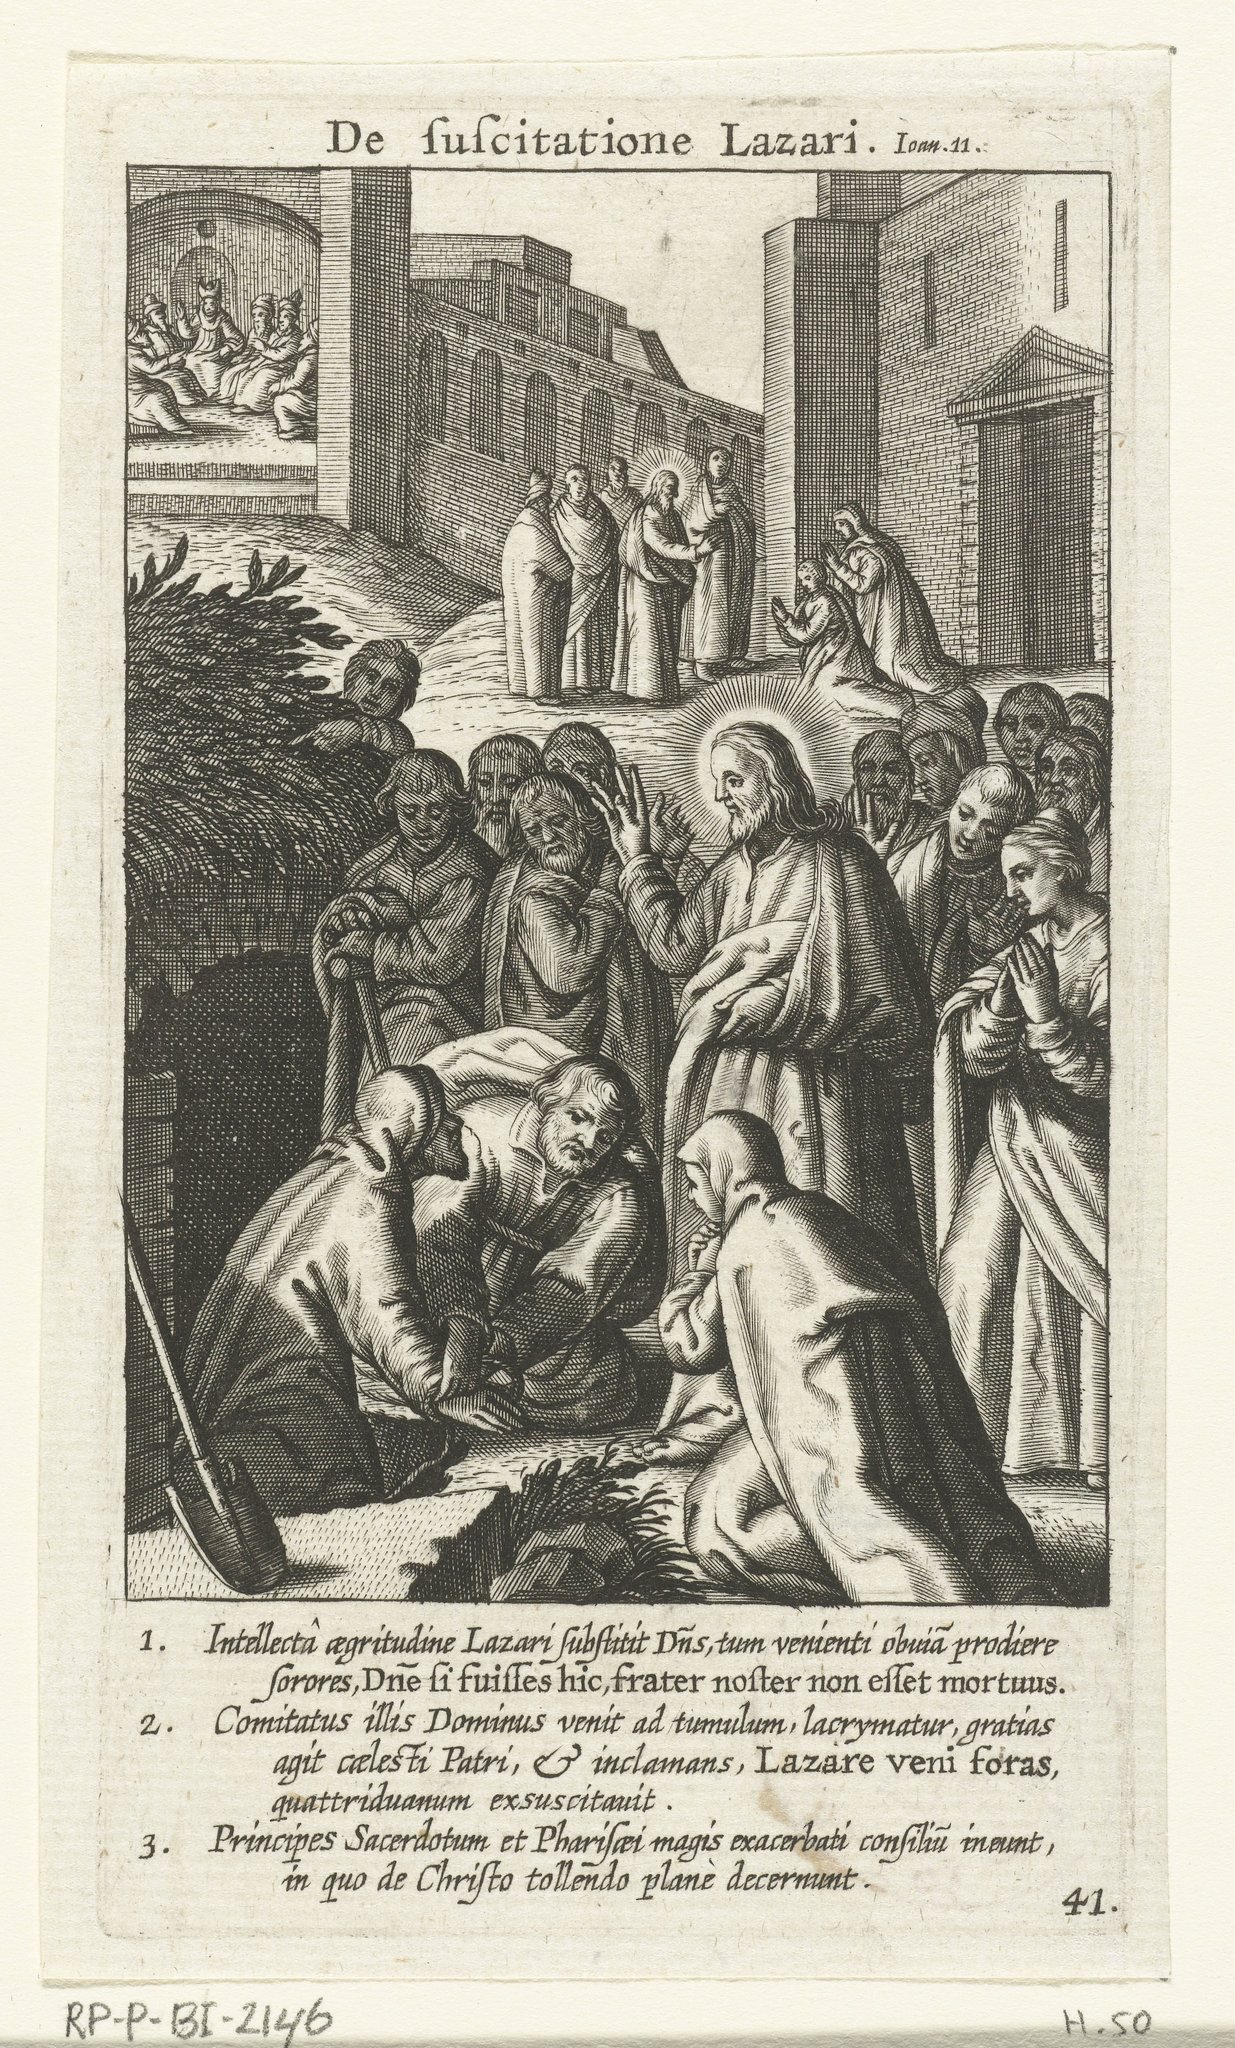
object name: print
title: Opwekking van Lazarus door Christus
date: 1590-1622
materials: paper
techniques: engraving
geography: antwerp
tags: the raising of lazarus ('lazarus, come out')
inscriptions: collector's mark: Lugt 240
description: Prent uit: Joannes Bourgois, Vitae passionis et mortis Jesu Christi Somini nostri mysteria, Antwerpen Hendrick Aertssens, 1622, afb. 41